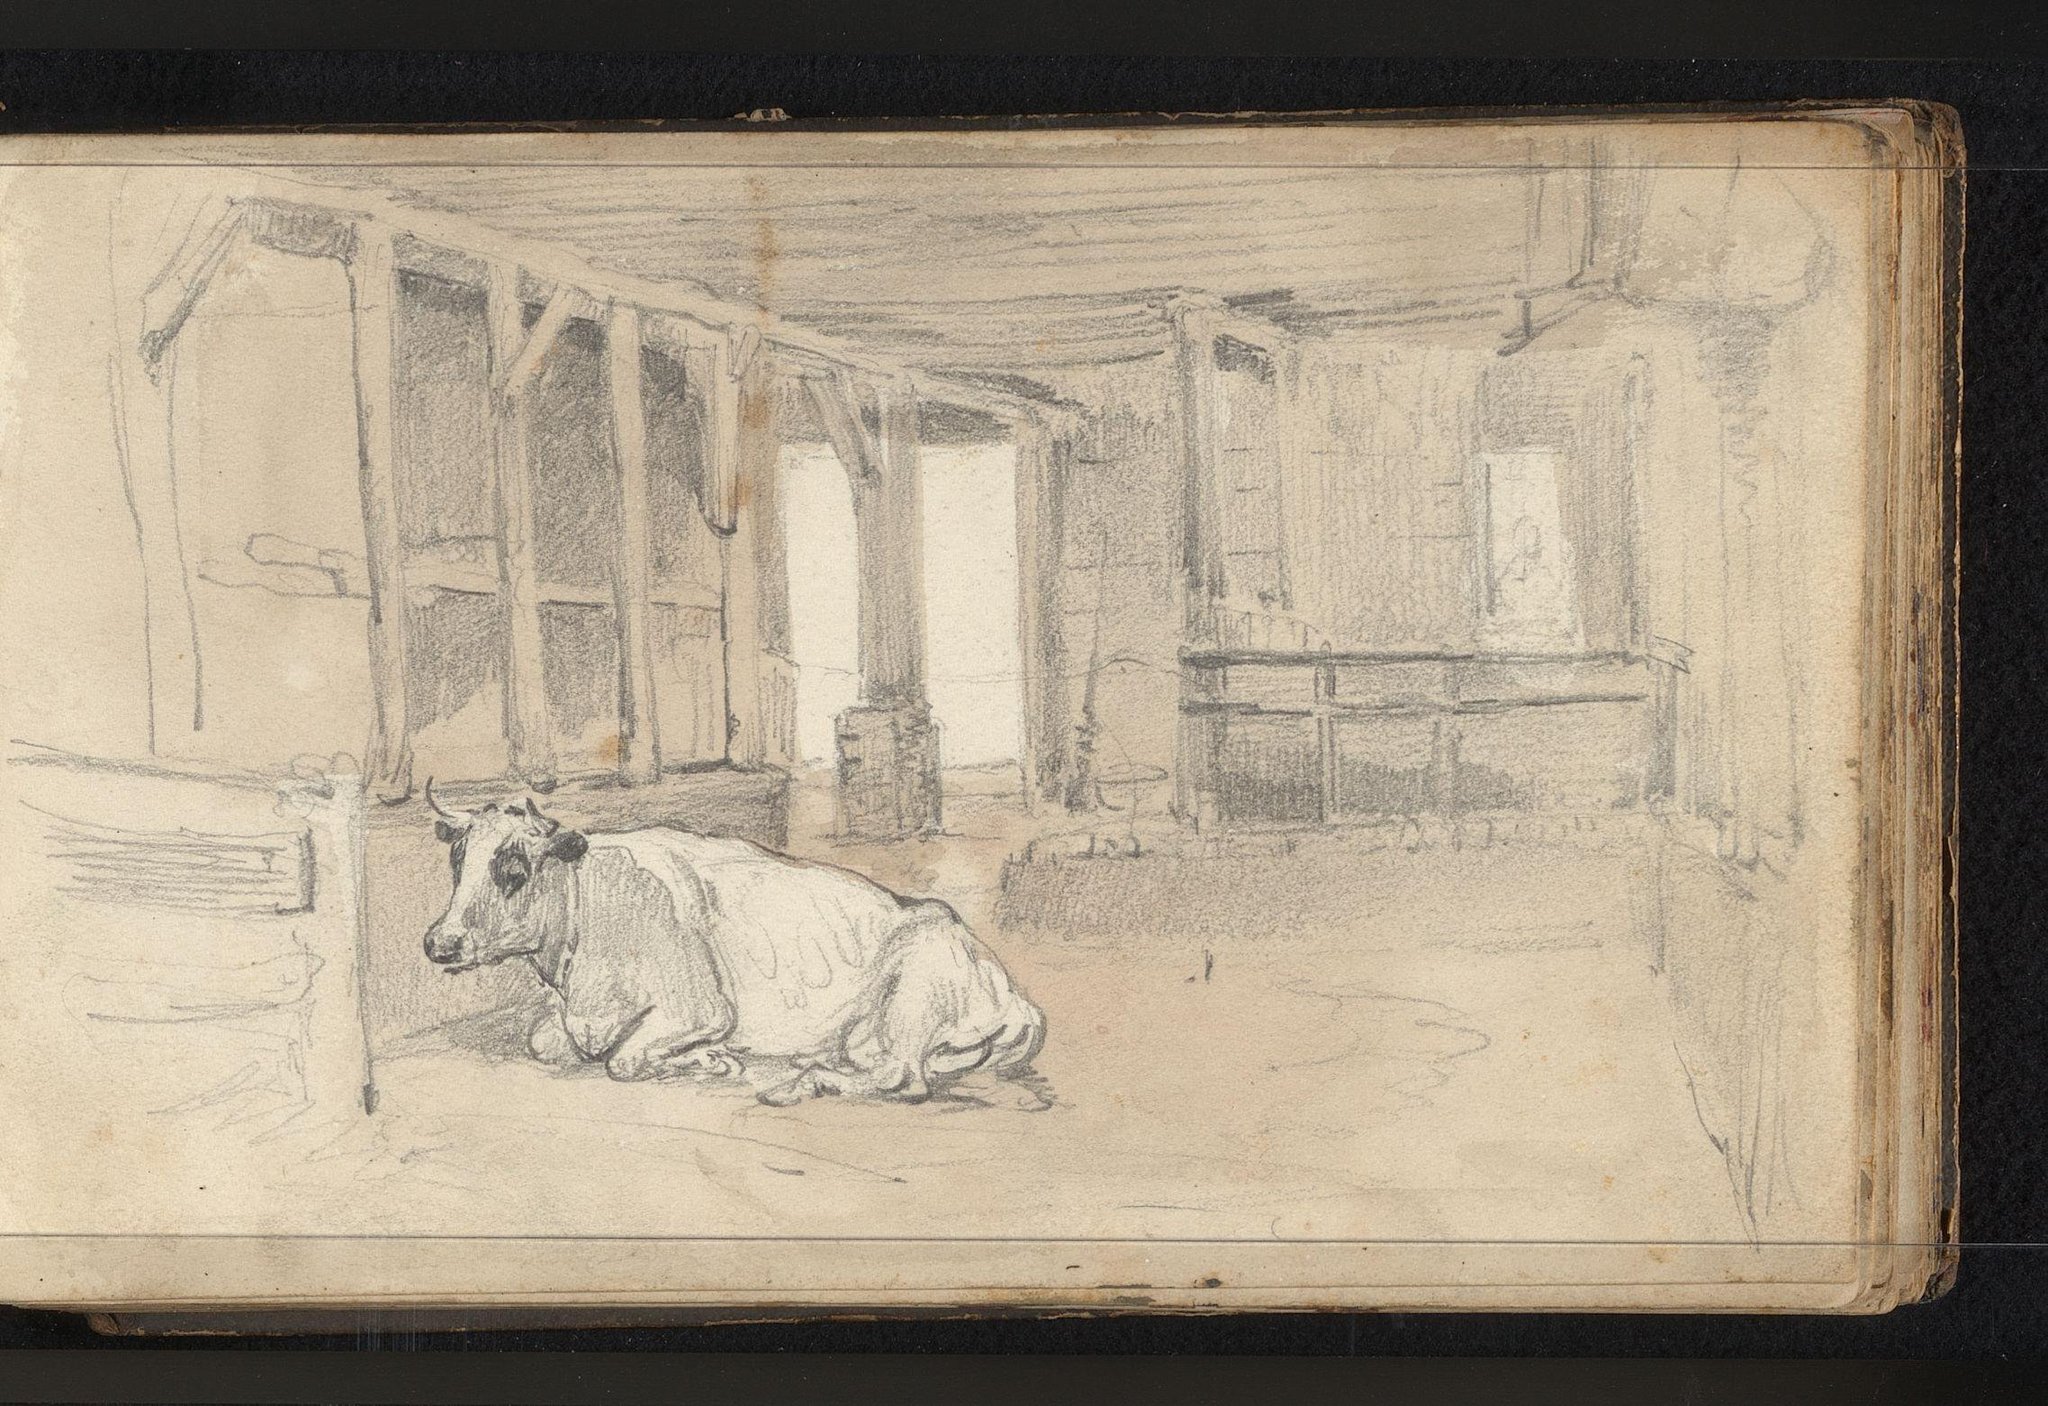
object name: sketchbook leaf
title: Stier liggend in een stal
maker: jan bedijs tom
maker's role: draughtsman, painter, print maker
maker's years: 1813-1894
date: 1828-1894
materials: paper, pencil, watercolor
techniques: brush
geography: the hague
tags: barn, bull, artist (in general) making preliminary designs, sketching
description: Pagina 52 verso uit een schetsboek met 54 bladen.